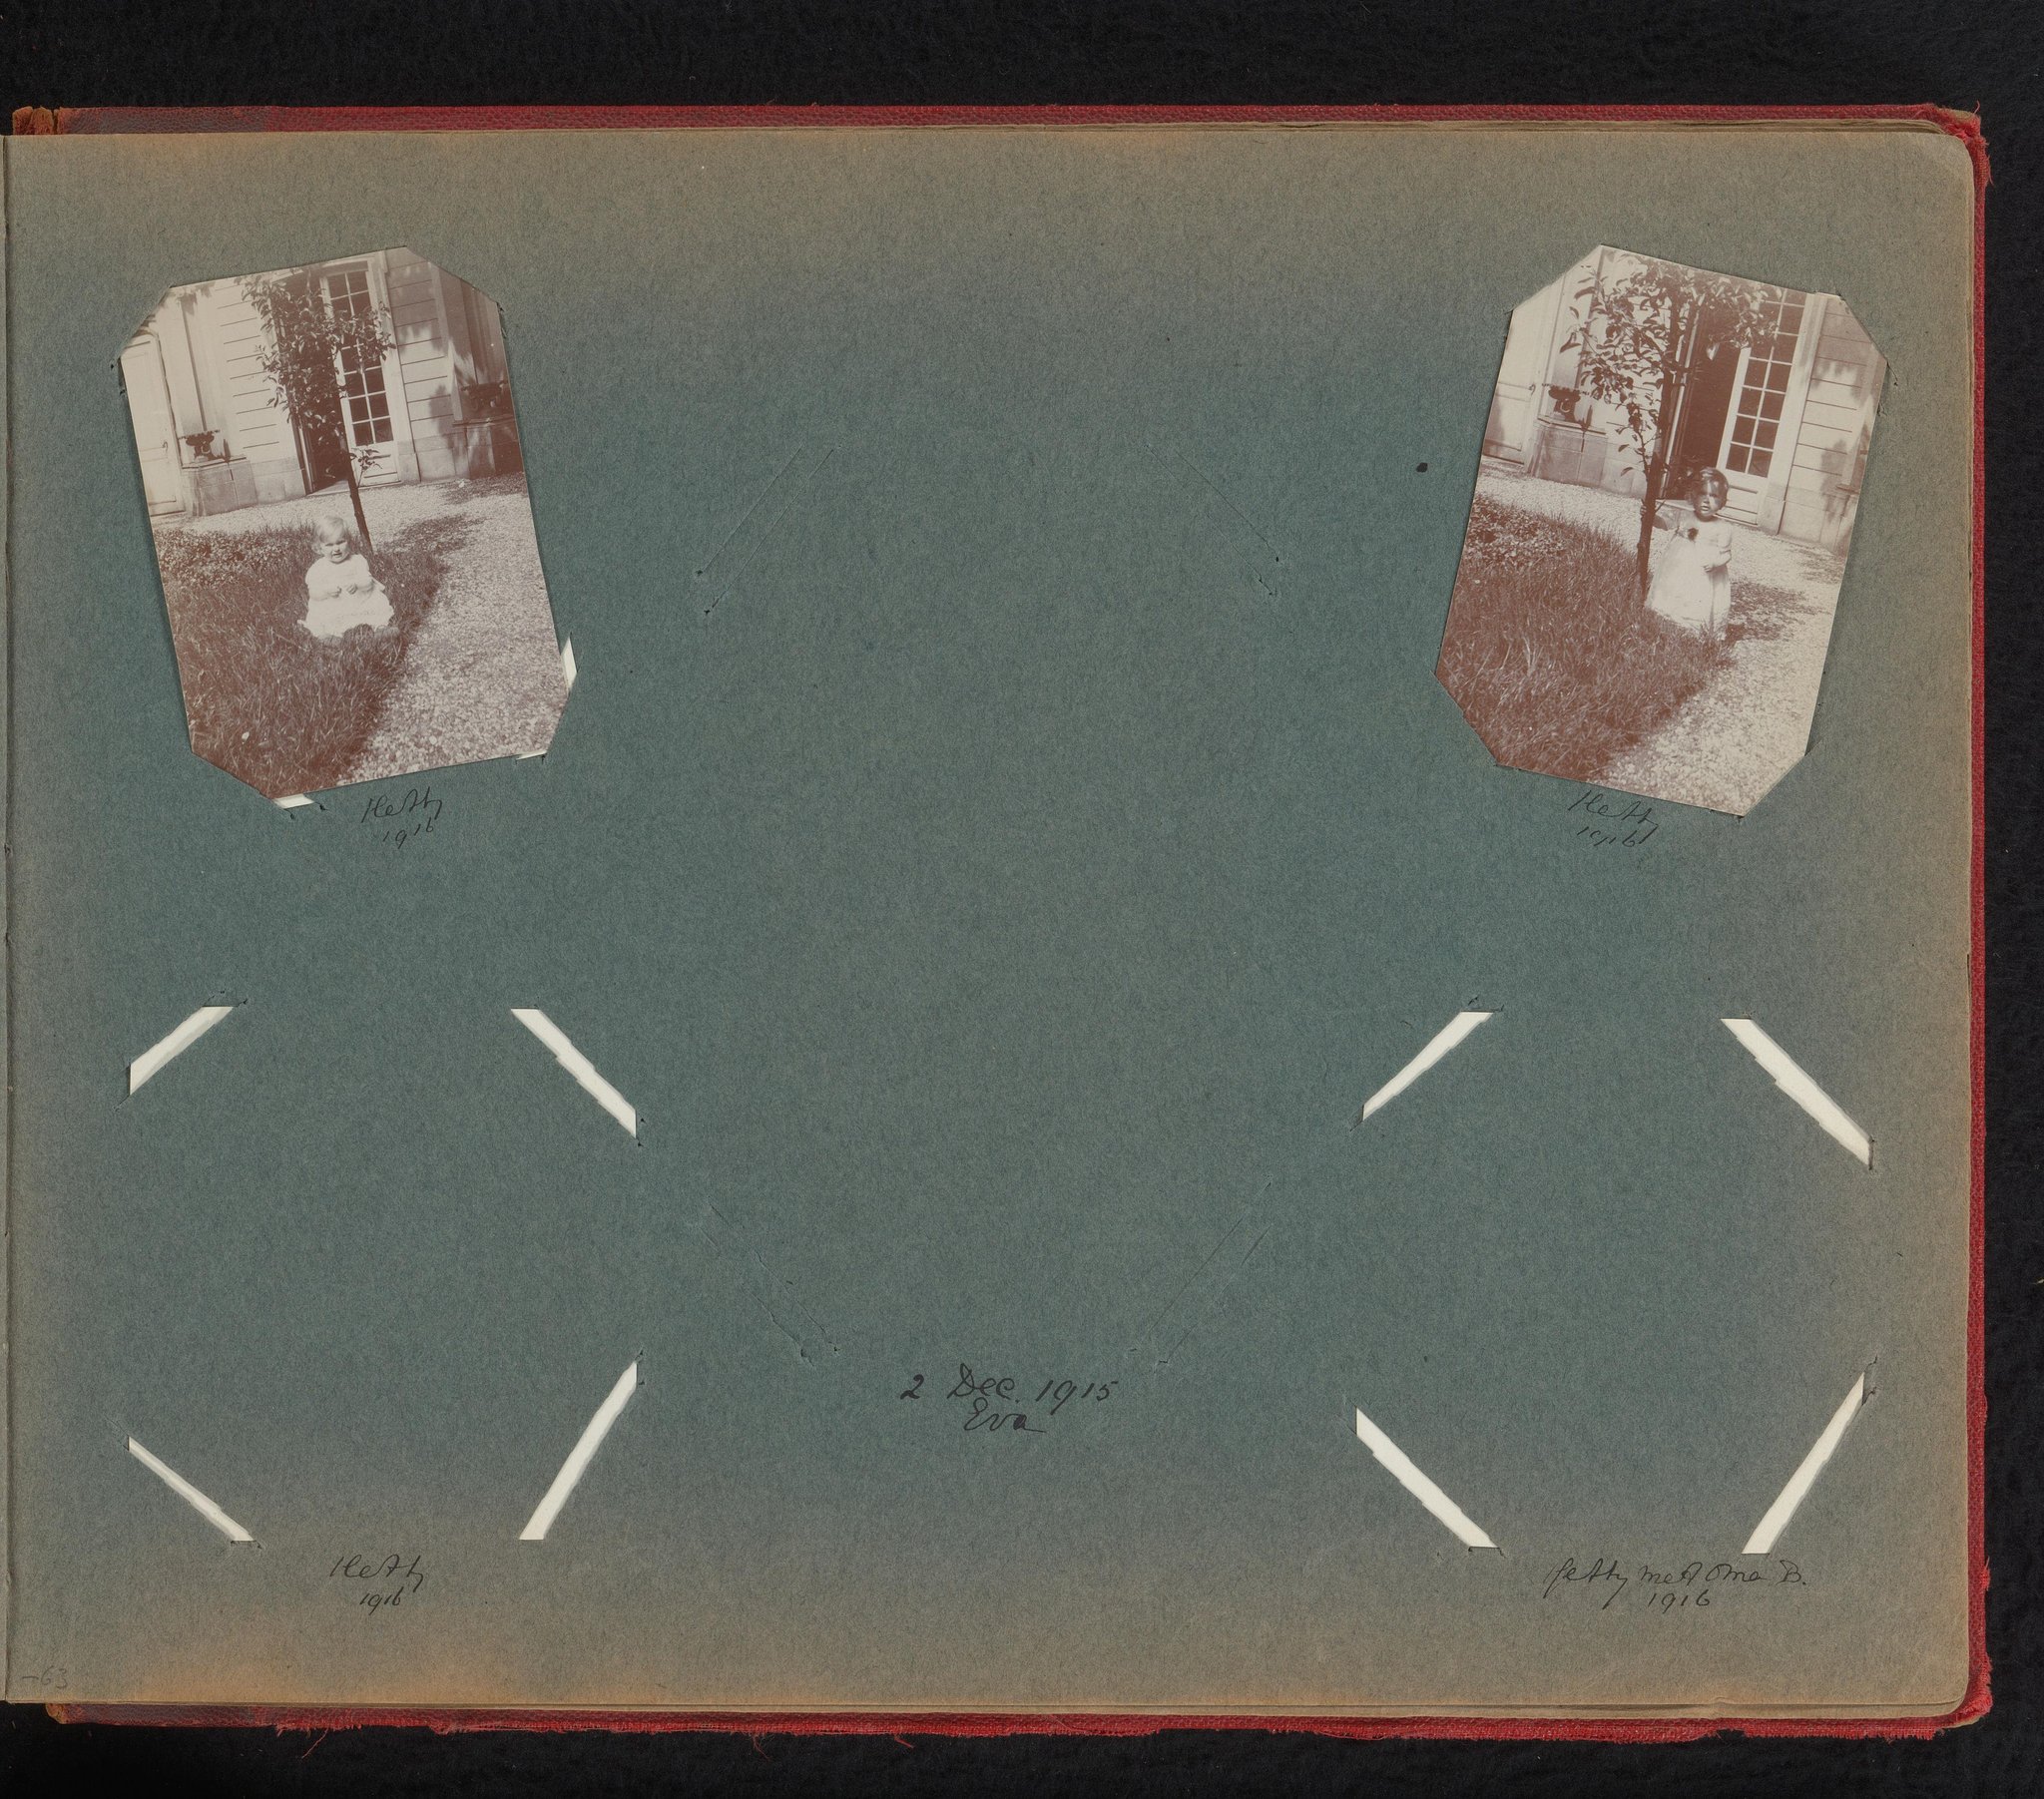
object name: photograph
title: Hetty Boelen in een tuin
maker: charlotte alida boelen-matthes (lot)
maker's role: amateurfotograaf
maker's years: 1889-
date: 1916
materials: paper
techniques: collodion silver print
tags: garden, toddler (female)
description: Deze foto's zijn onderdeel van een album.